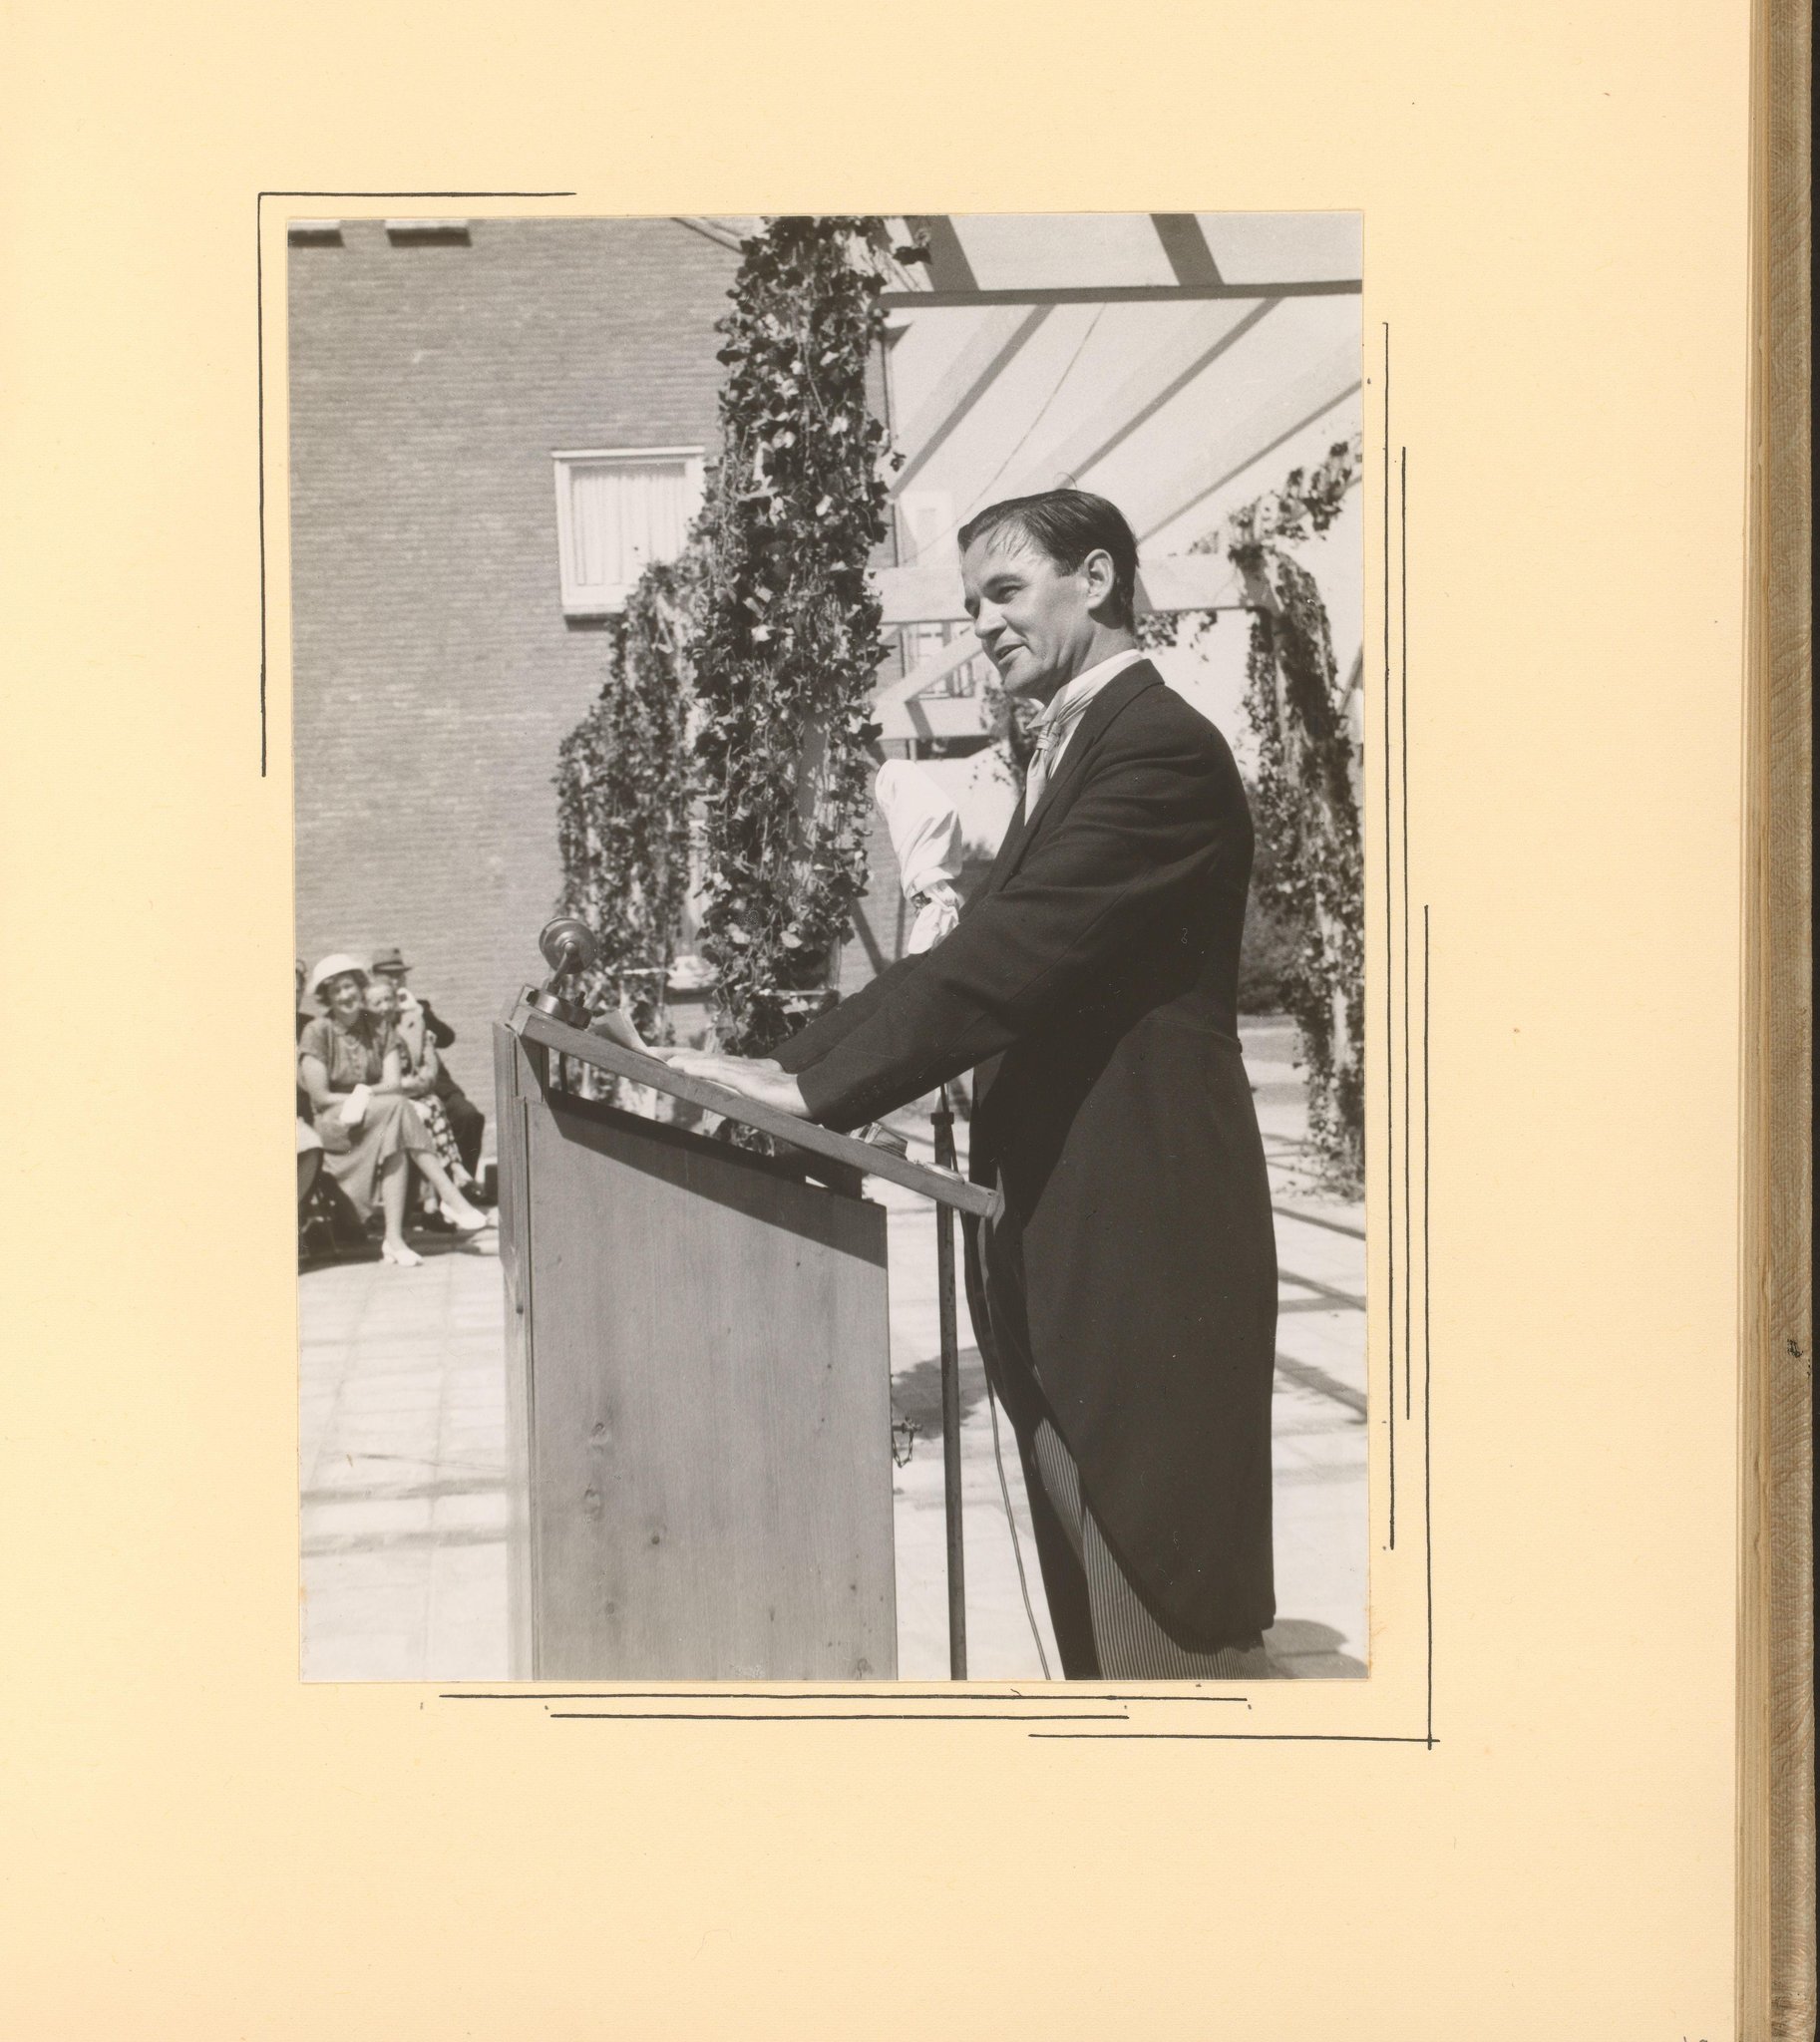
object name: photograph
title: Toespraak van Tangelder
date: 1953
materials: paper, photographic support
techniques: gelatin silver print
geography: lochem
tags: the hague, willem drees, prime minister, activities in the air ~ public festivities, e.g. fly-past, old-people's home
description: Toespraak van ds. T.H.T.G. Tangelder, voorzitter van de Stichting Maatschappelijk Werk. Onderdeel van het fotoalbum over de opening van bejaardenhuis De Berkelhof in Lochem door Dr. W. Drees op 8 augustus 1953.